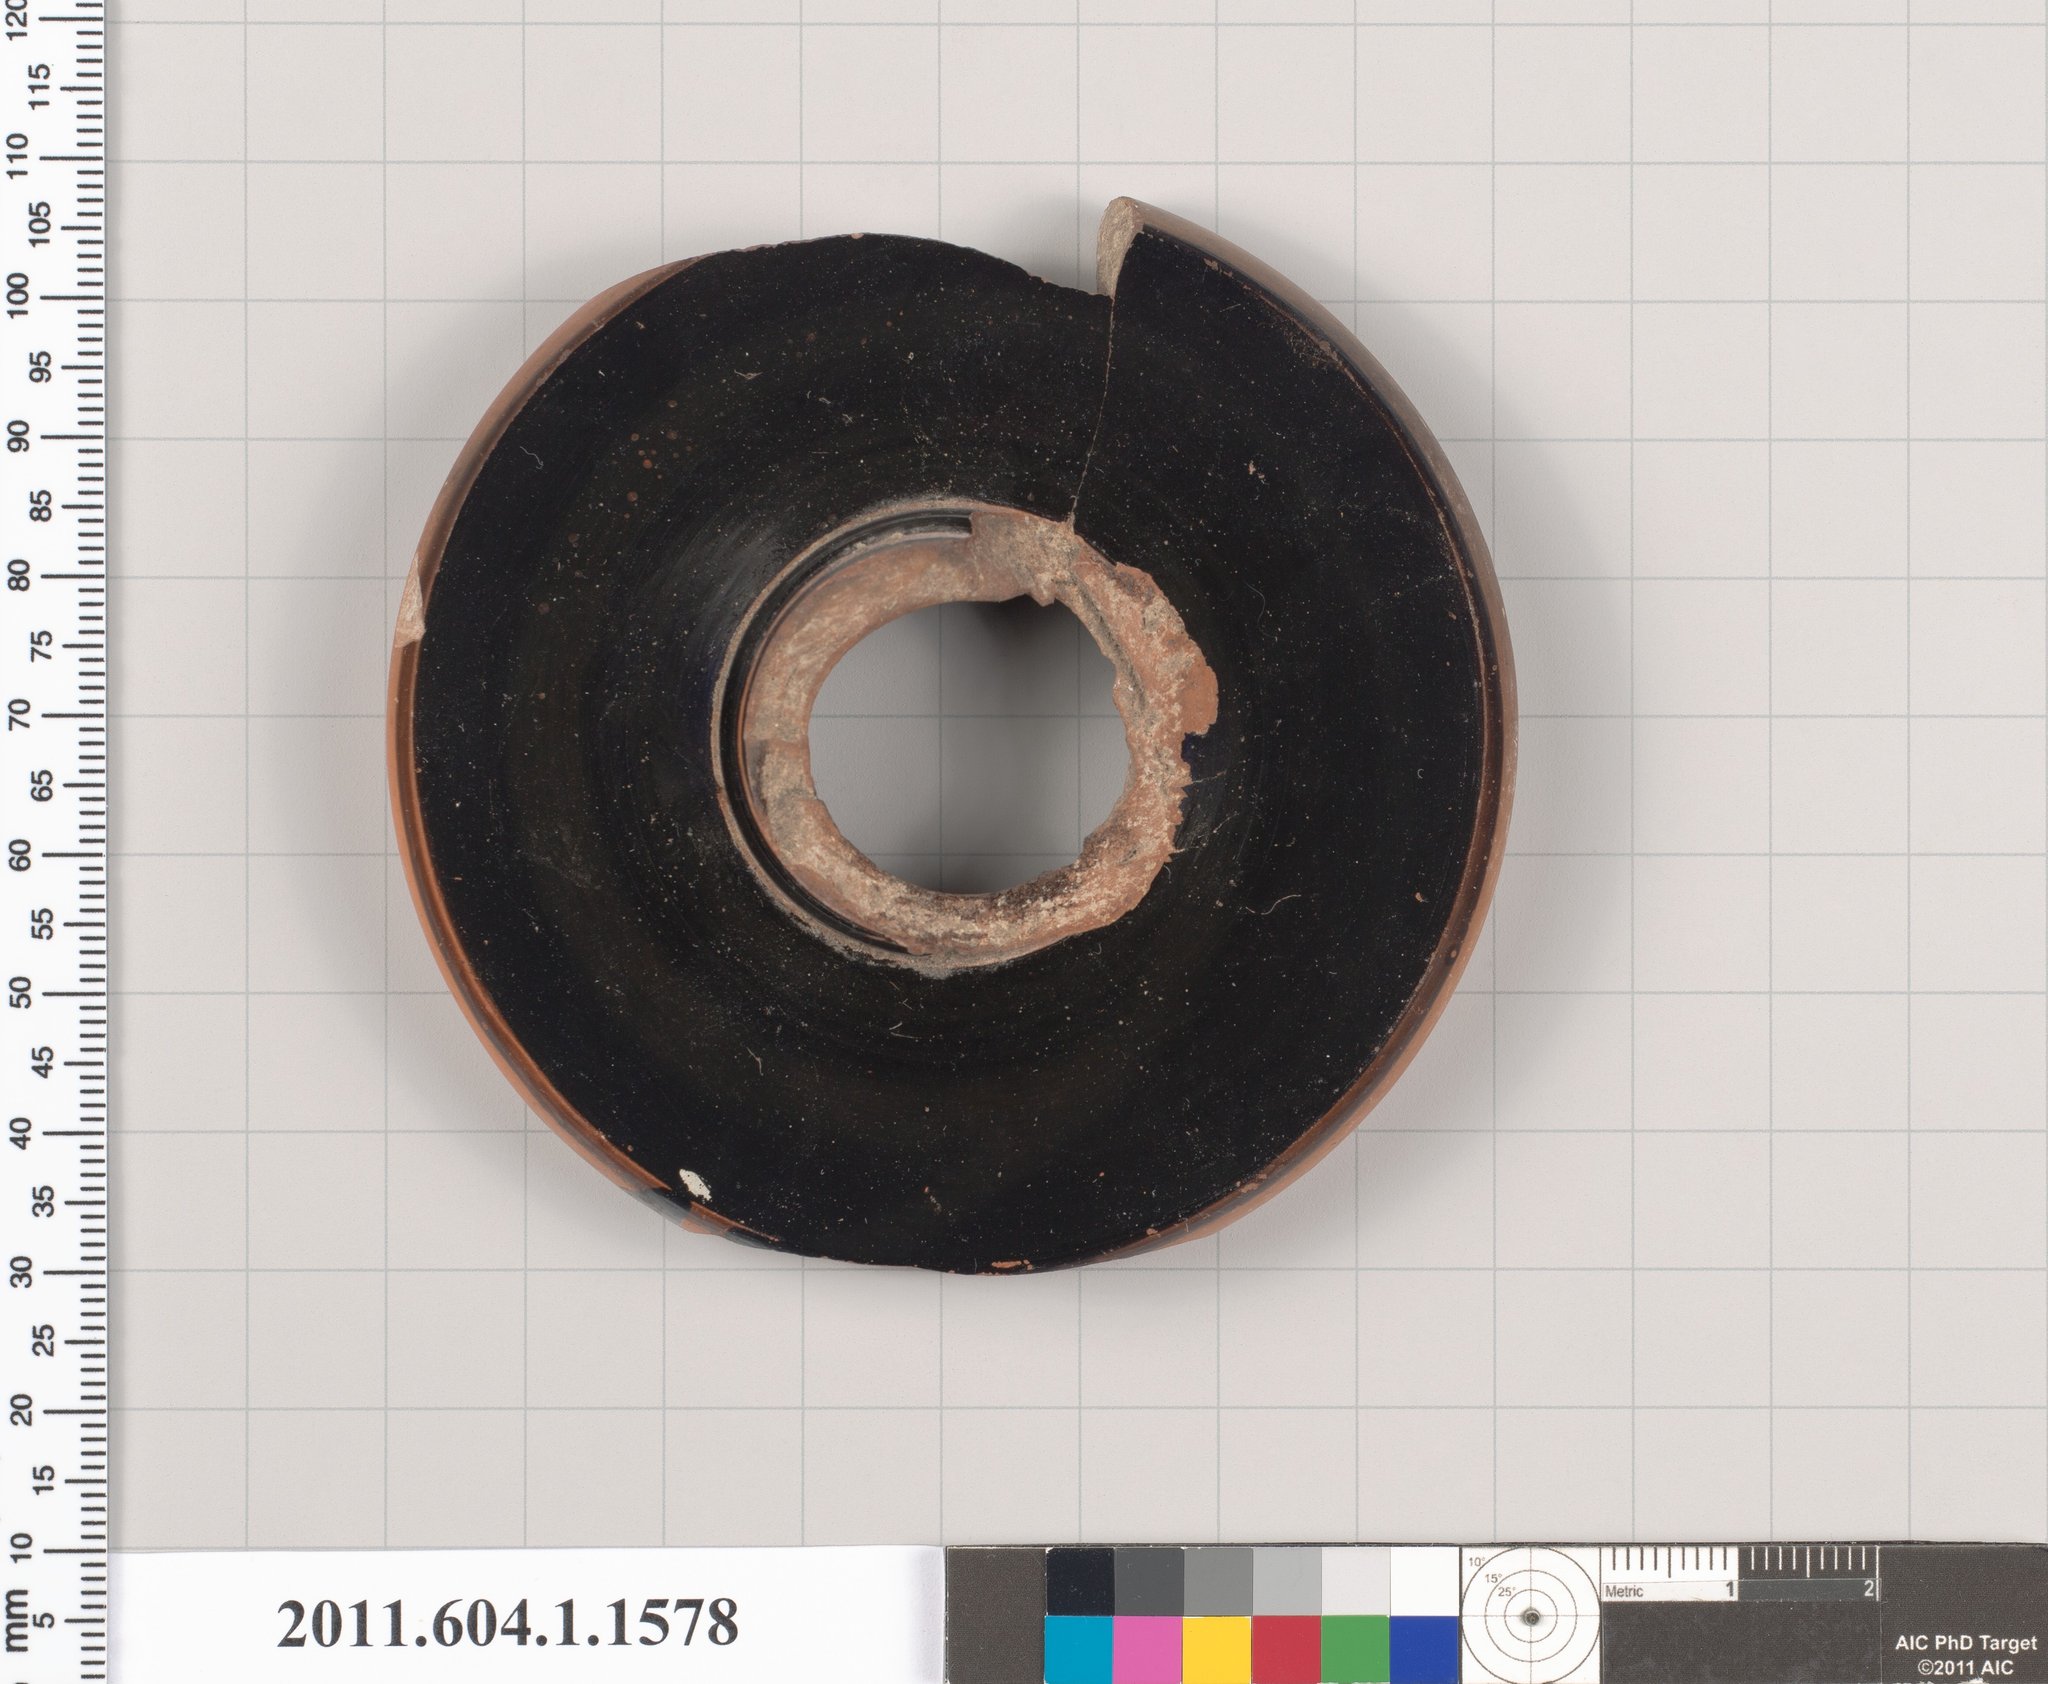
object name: kylix fragment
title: Terracotta fragment of a kylix (drinking cup)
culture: greek, attic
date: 500-401 BCE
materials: terracotta